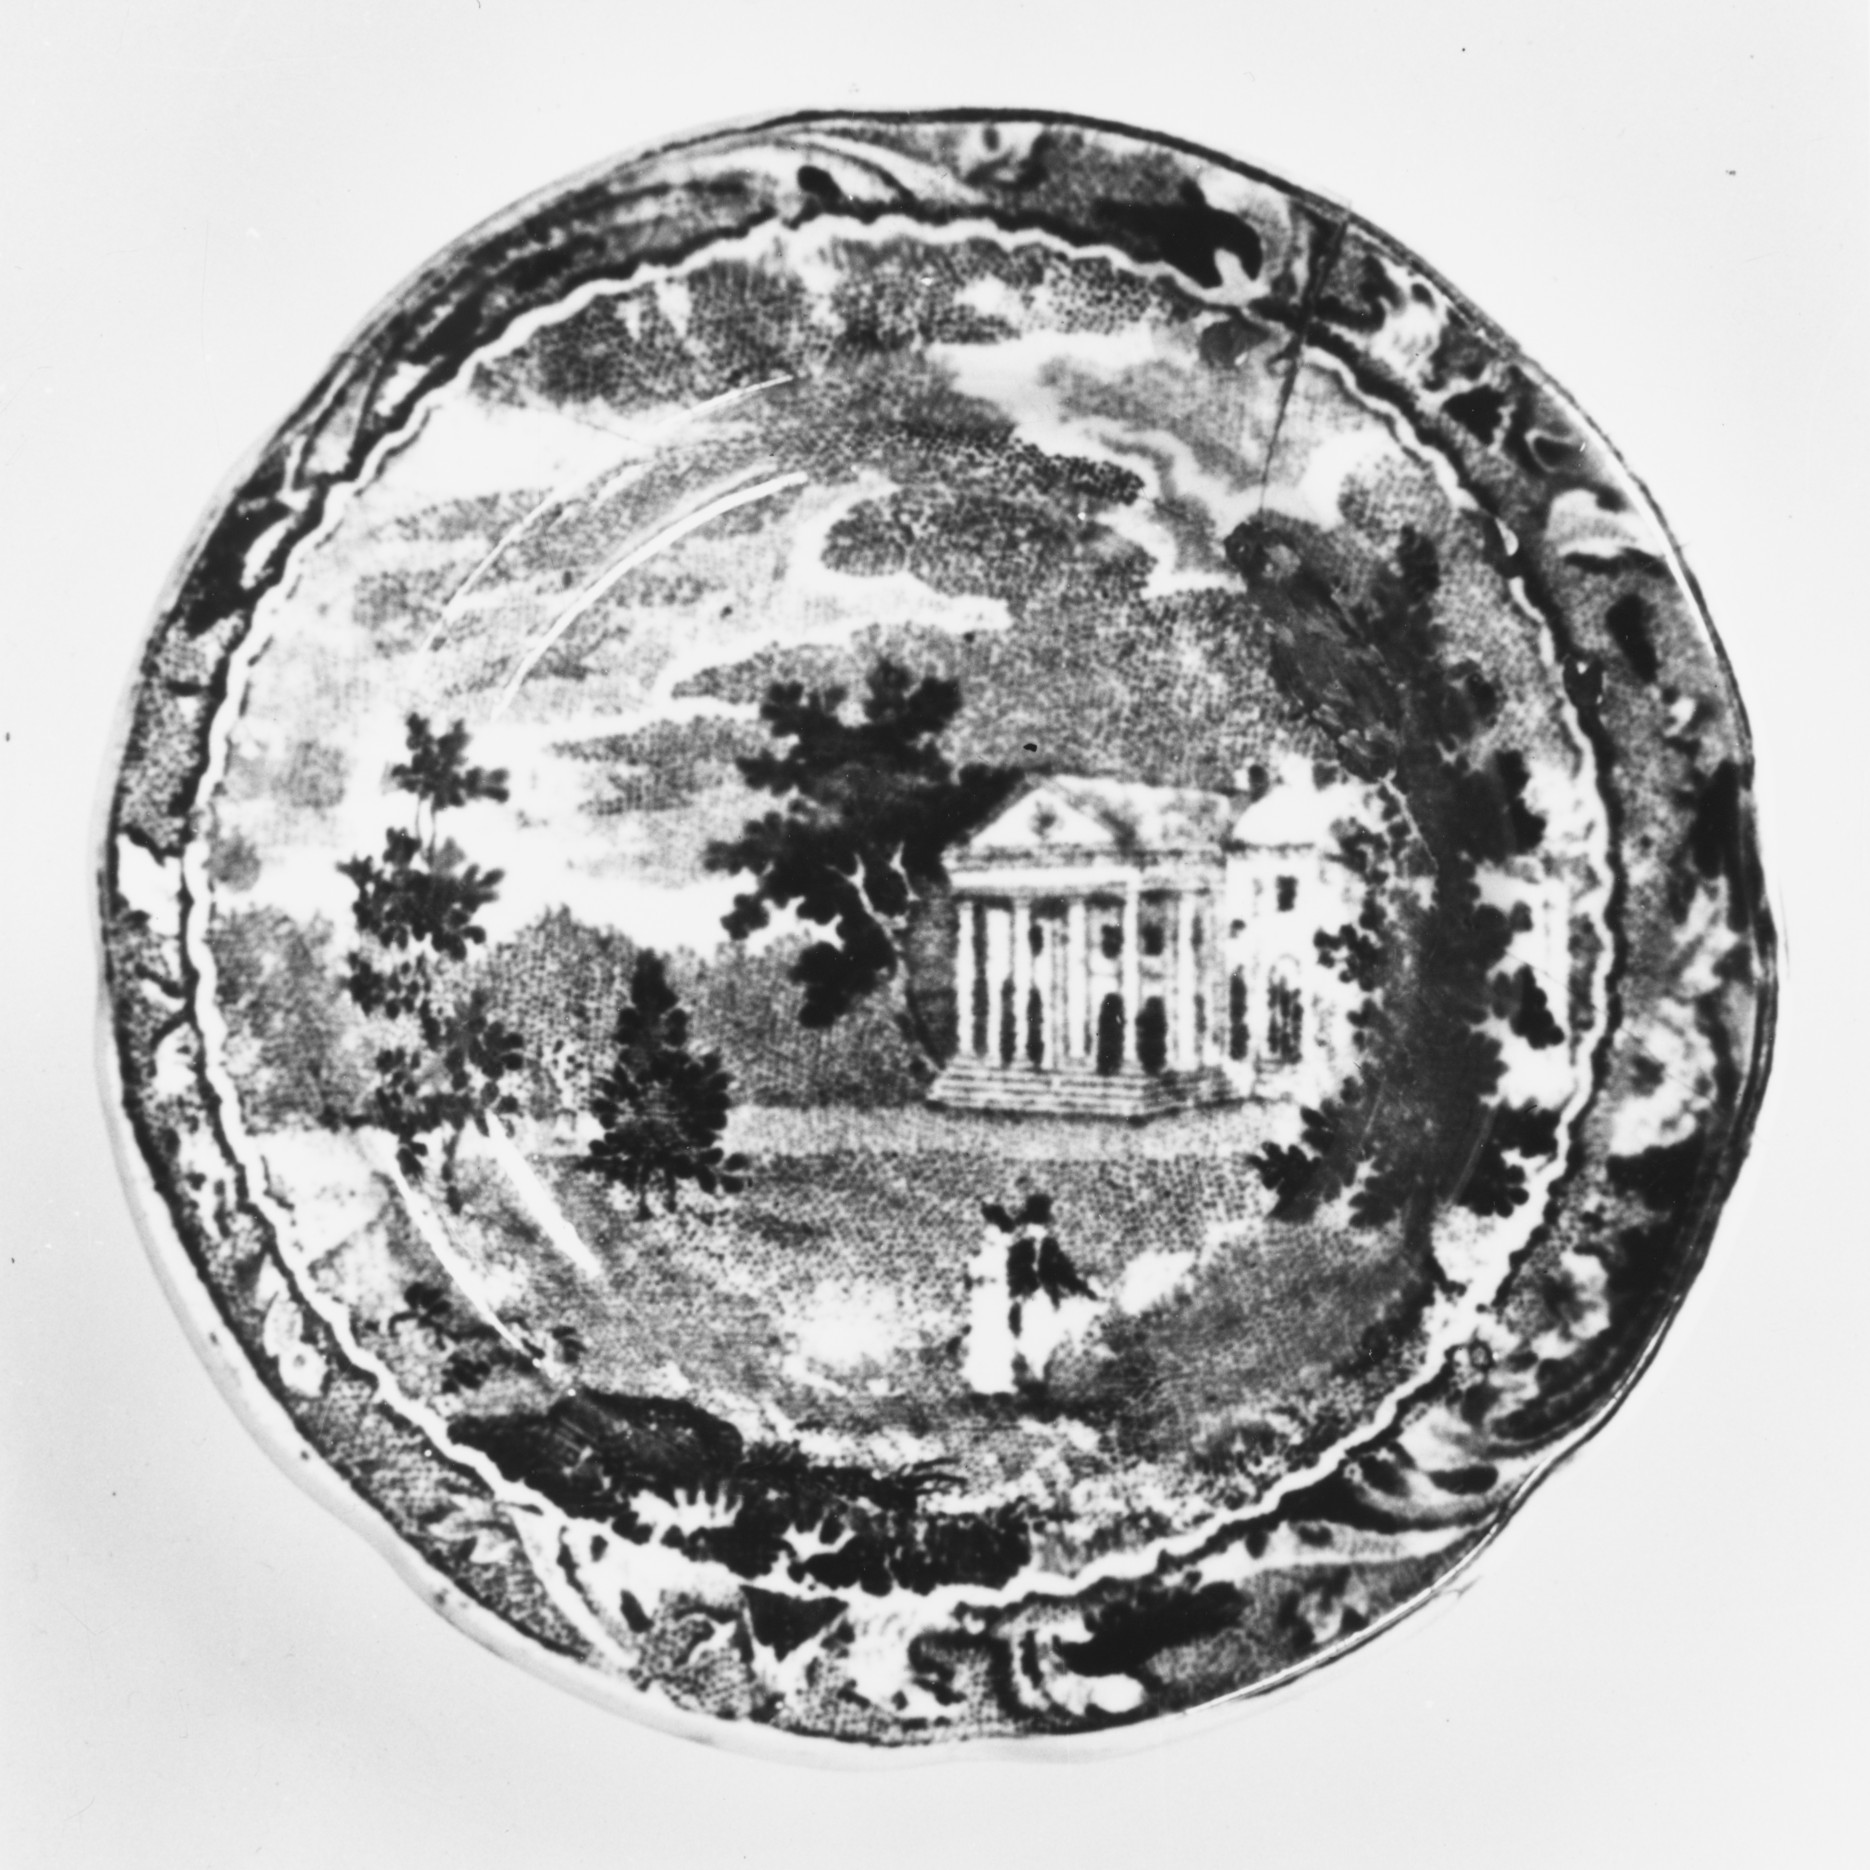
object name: plate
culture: british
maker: joseph stubbs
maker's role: maker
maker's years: 1819-1836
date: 1822-1836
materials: earthenware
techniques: transfer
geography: england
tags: houses,landscapes